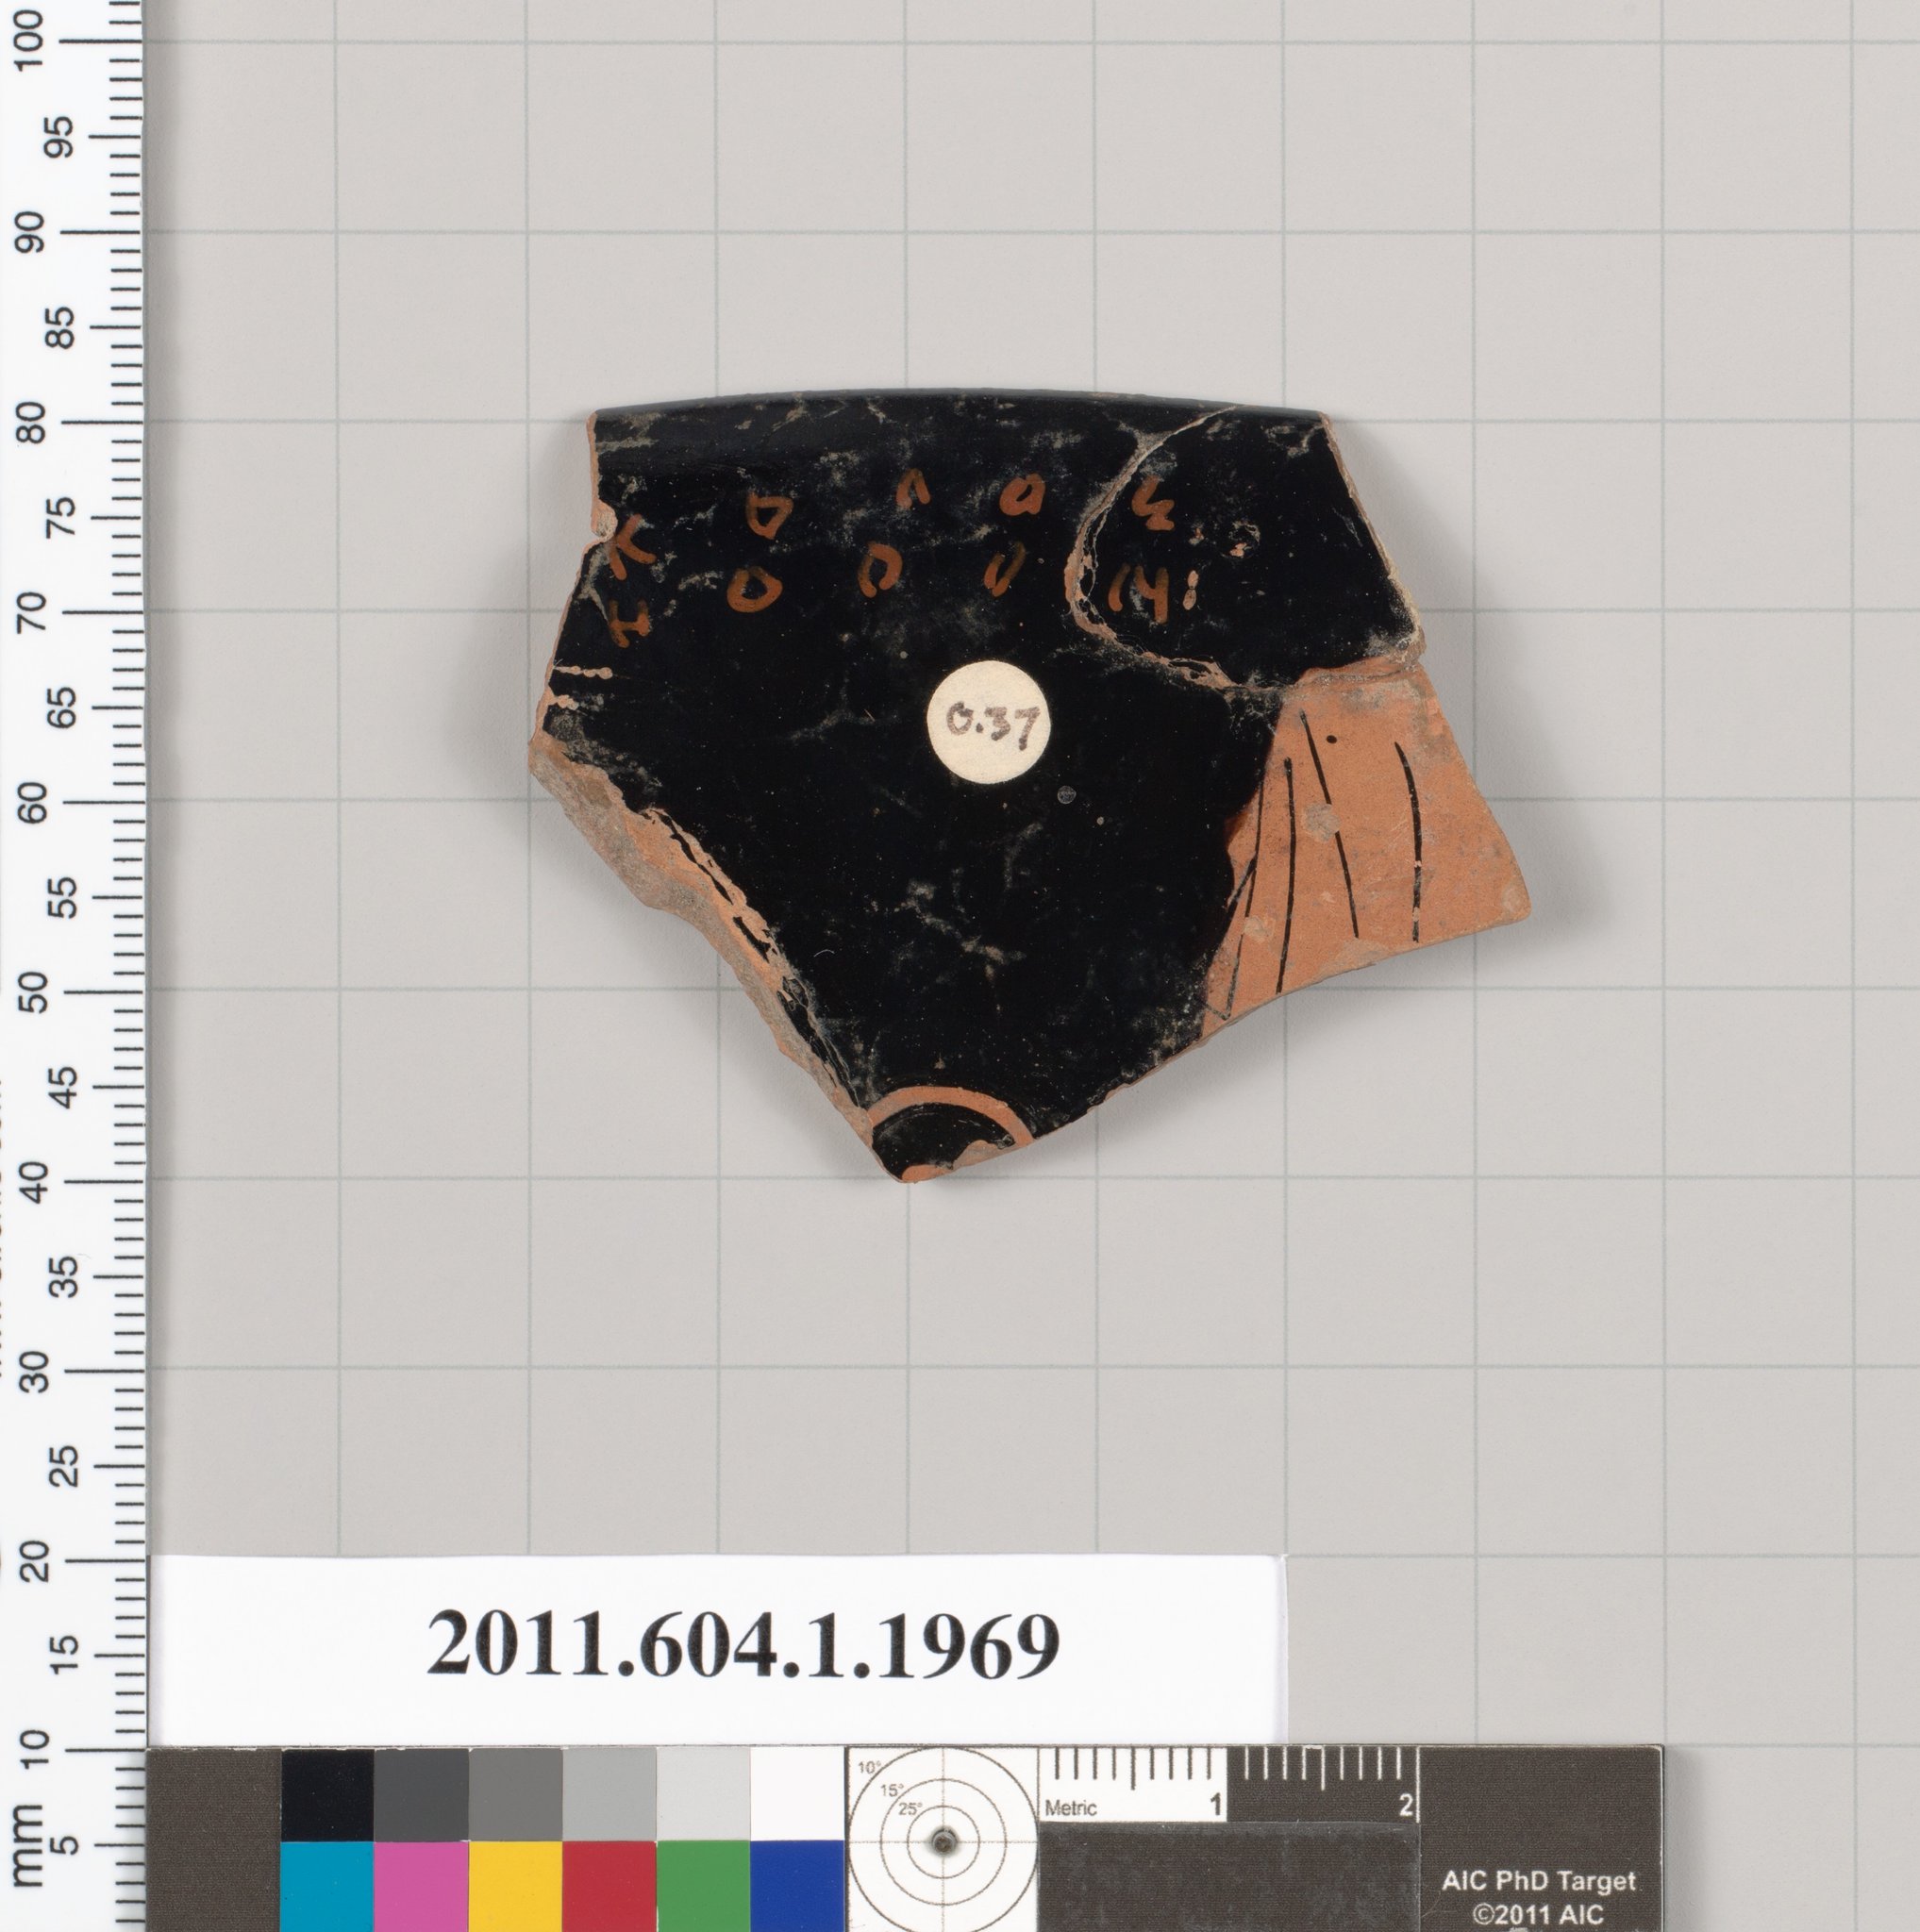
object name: kylix fragment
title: Terracotta rim fragment of a kylix (drinking cup)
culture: greek, attic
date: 475-451 BCE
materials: terracotta